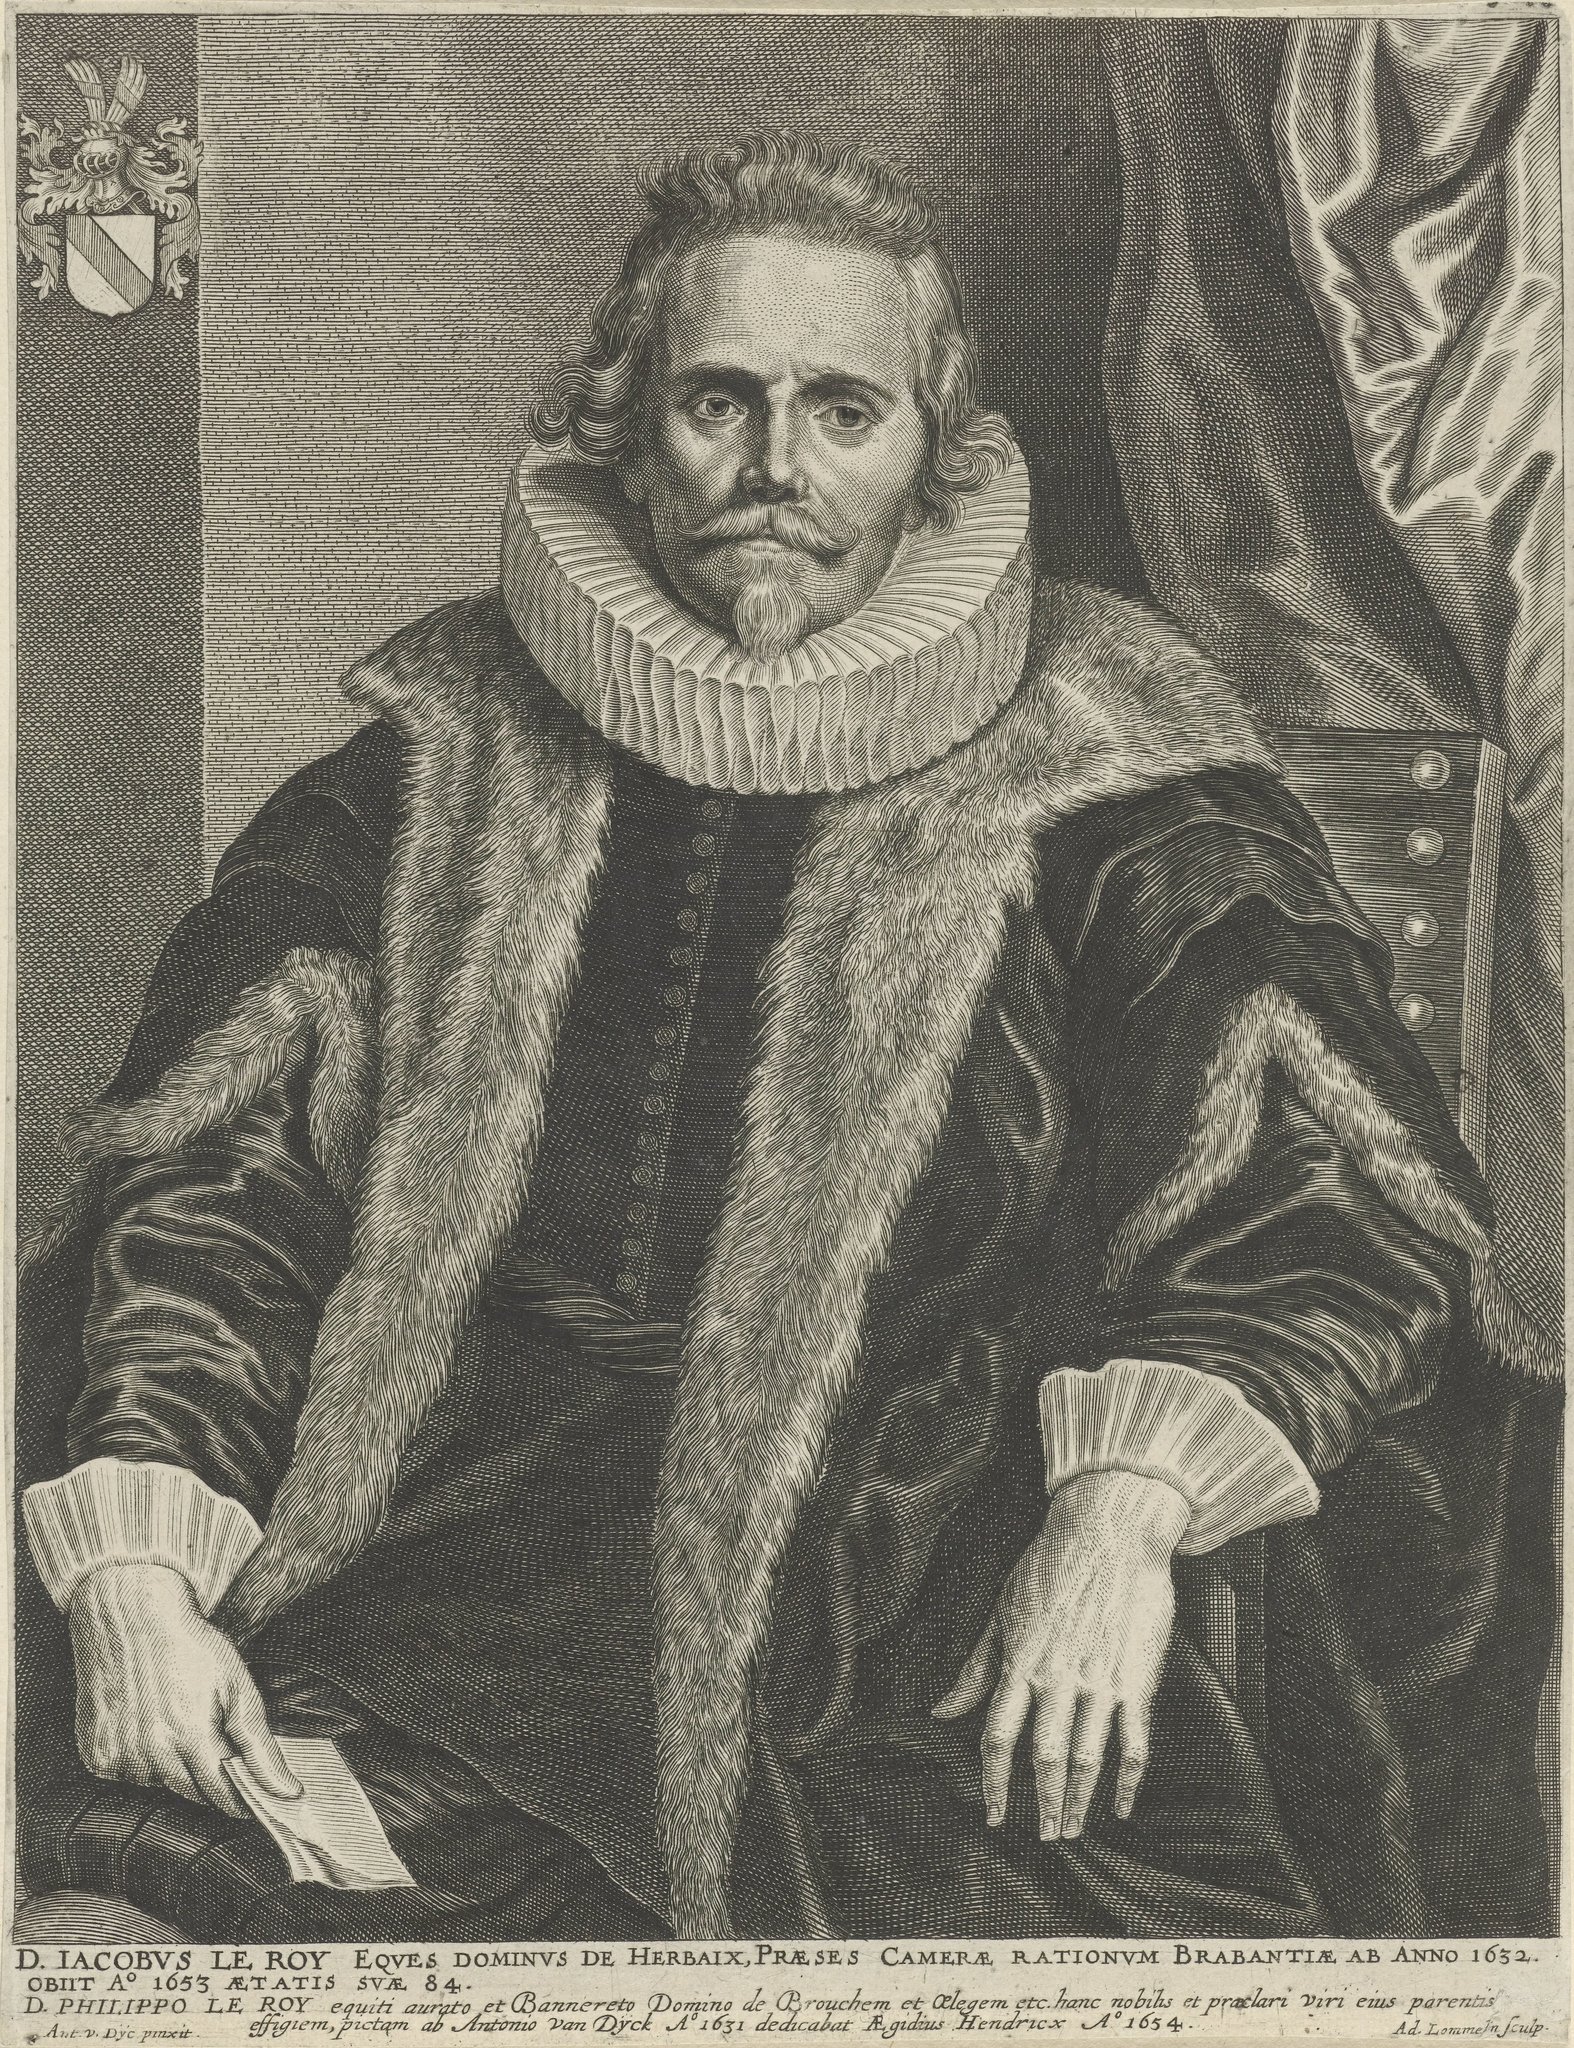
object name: print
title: Portret van Jacques Le Roy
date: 1630-1677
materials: paper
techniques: engraving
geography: antwerp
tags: official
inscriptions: collector's mark: Lugt 240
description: Portret van Jacques le Roy, hoogwaardigheidsbekleder aan het hof in Brussel.